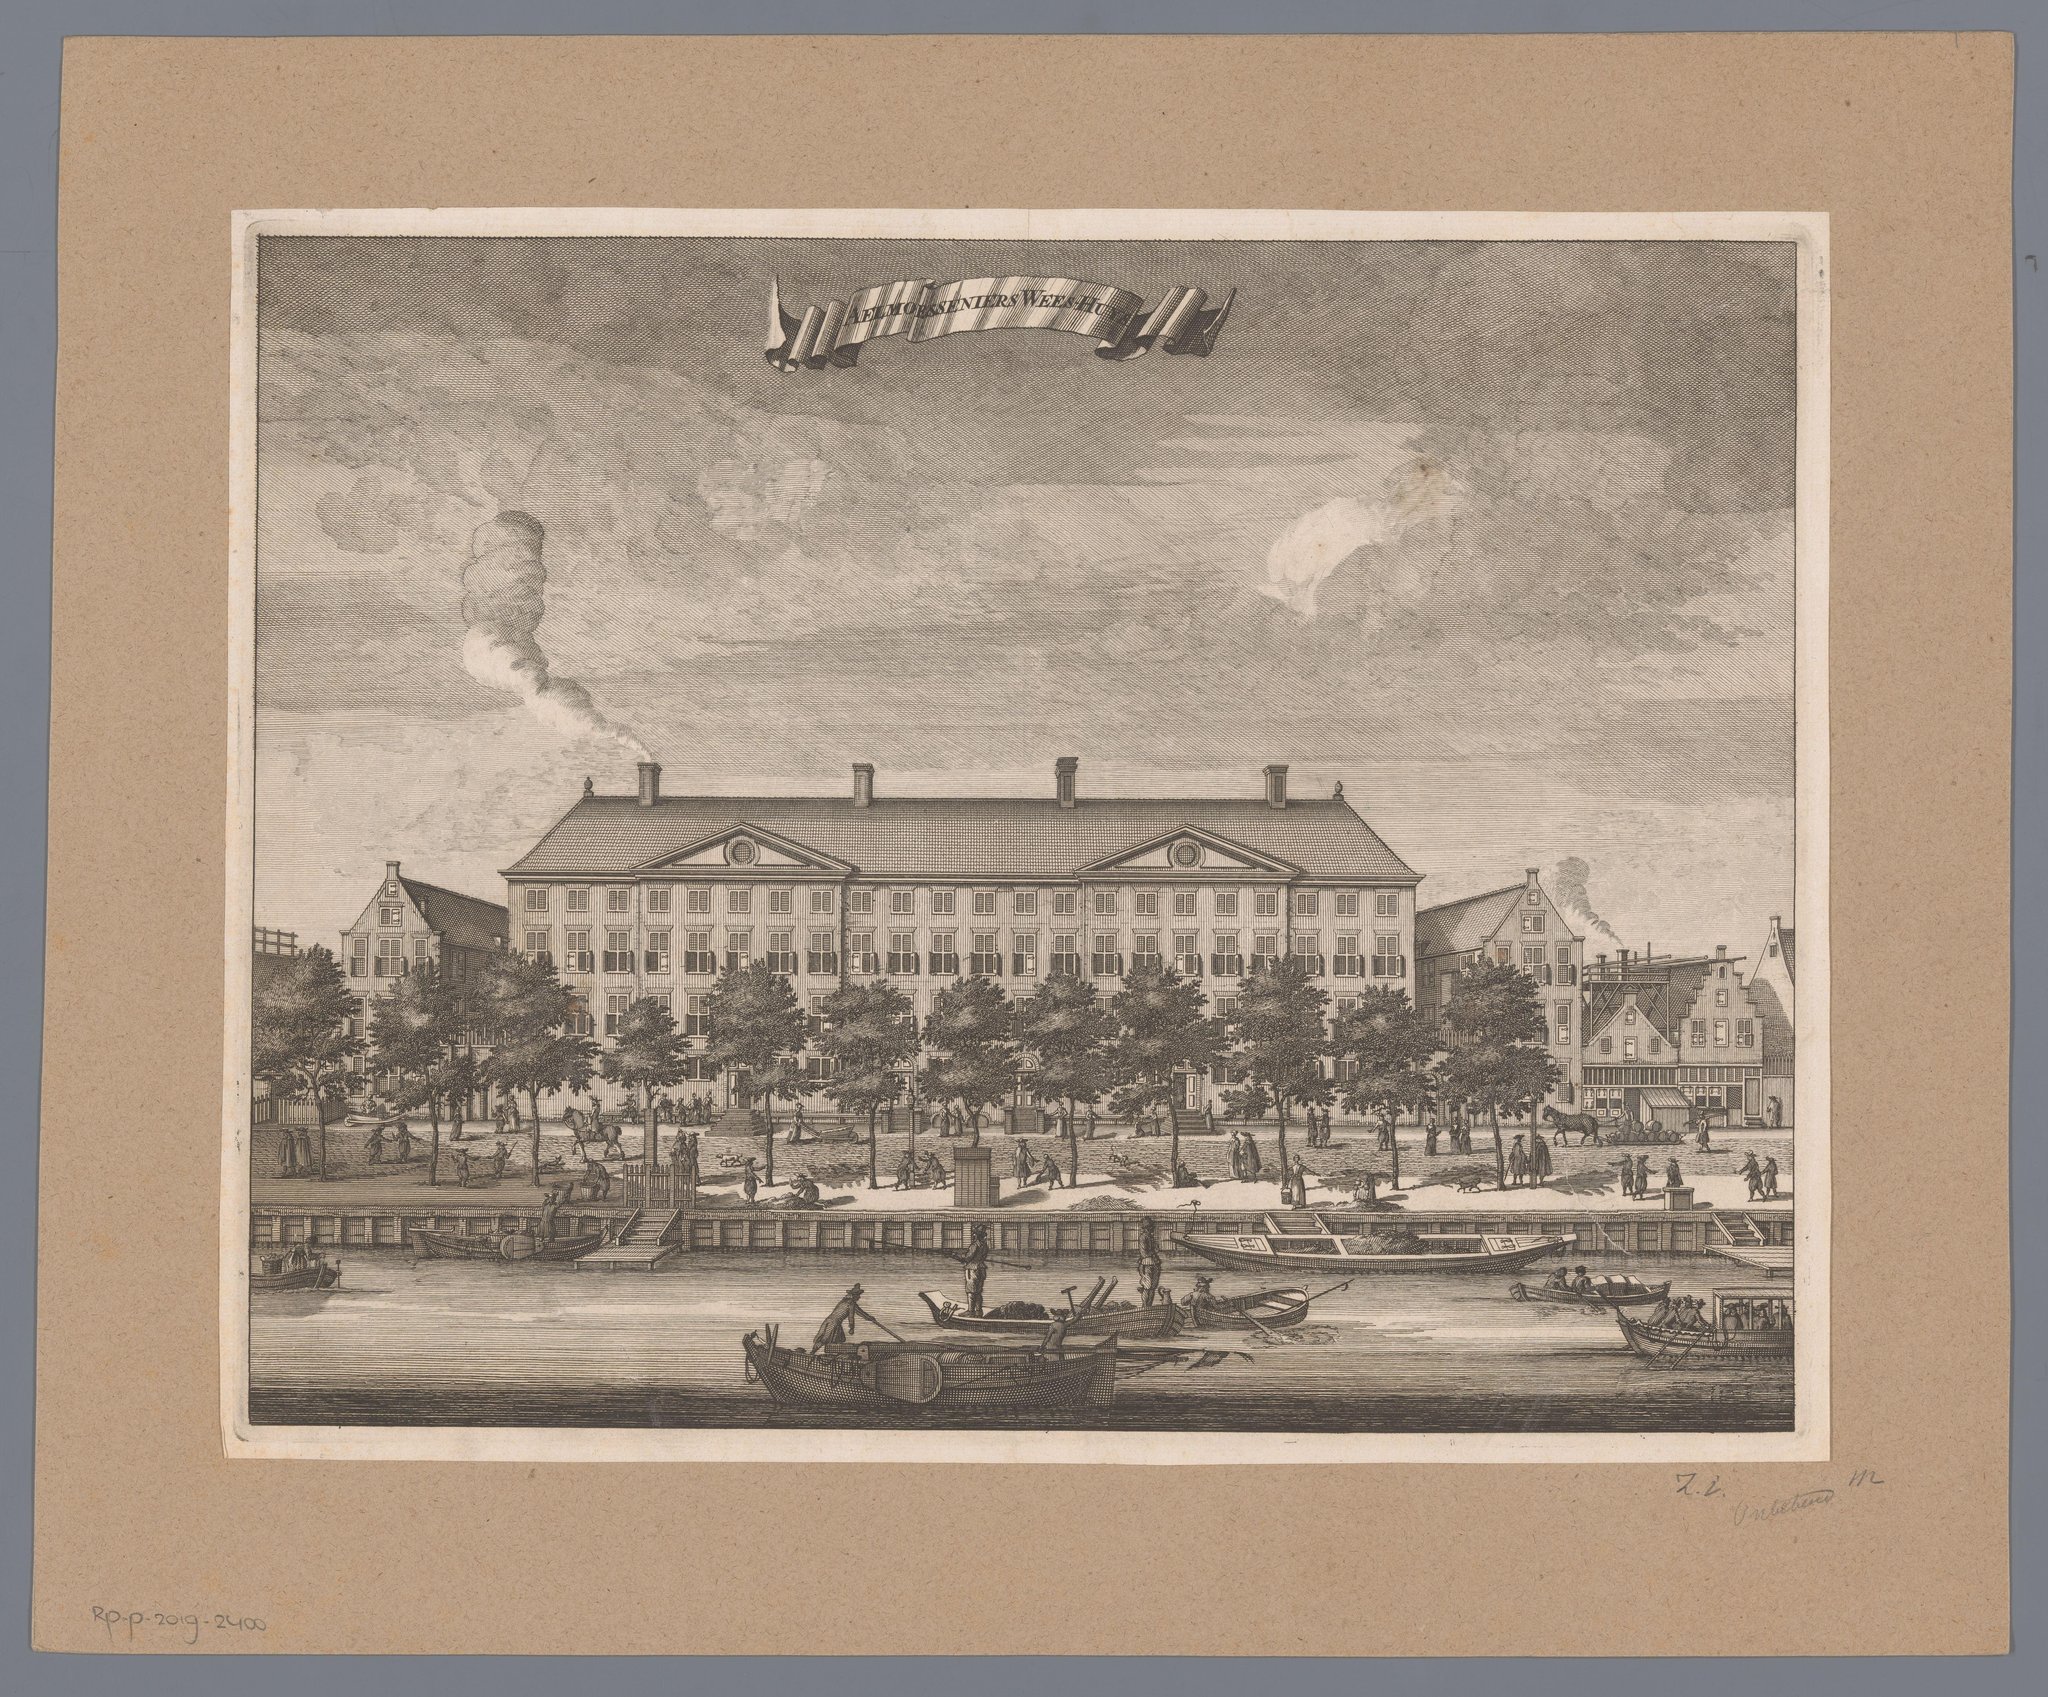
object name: print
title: Aelmoesseniers Wees-huys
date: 1693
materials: paper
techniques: engraving, etching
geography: amsterdam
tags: orphanage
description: Prent uit: Commelin, Caspar. Beschryvinge van Amsterdam (...). 2 dln. Amsterdam: Weduwe Dircksz. Oossaan, 1693, dl. 2, p. 588-589.